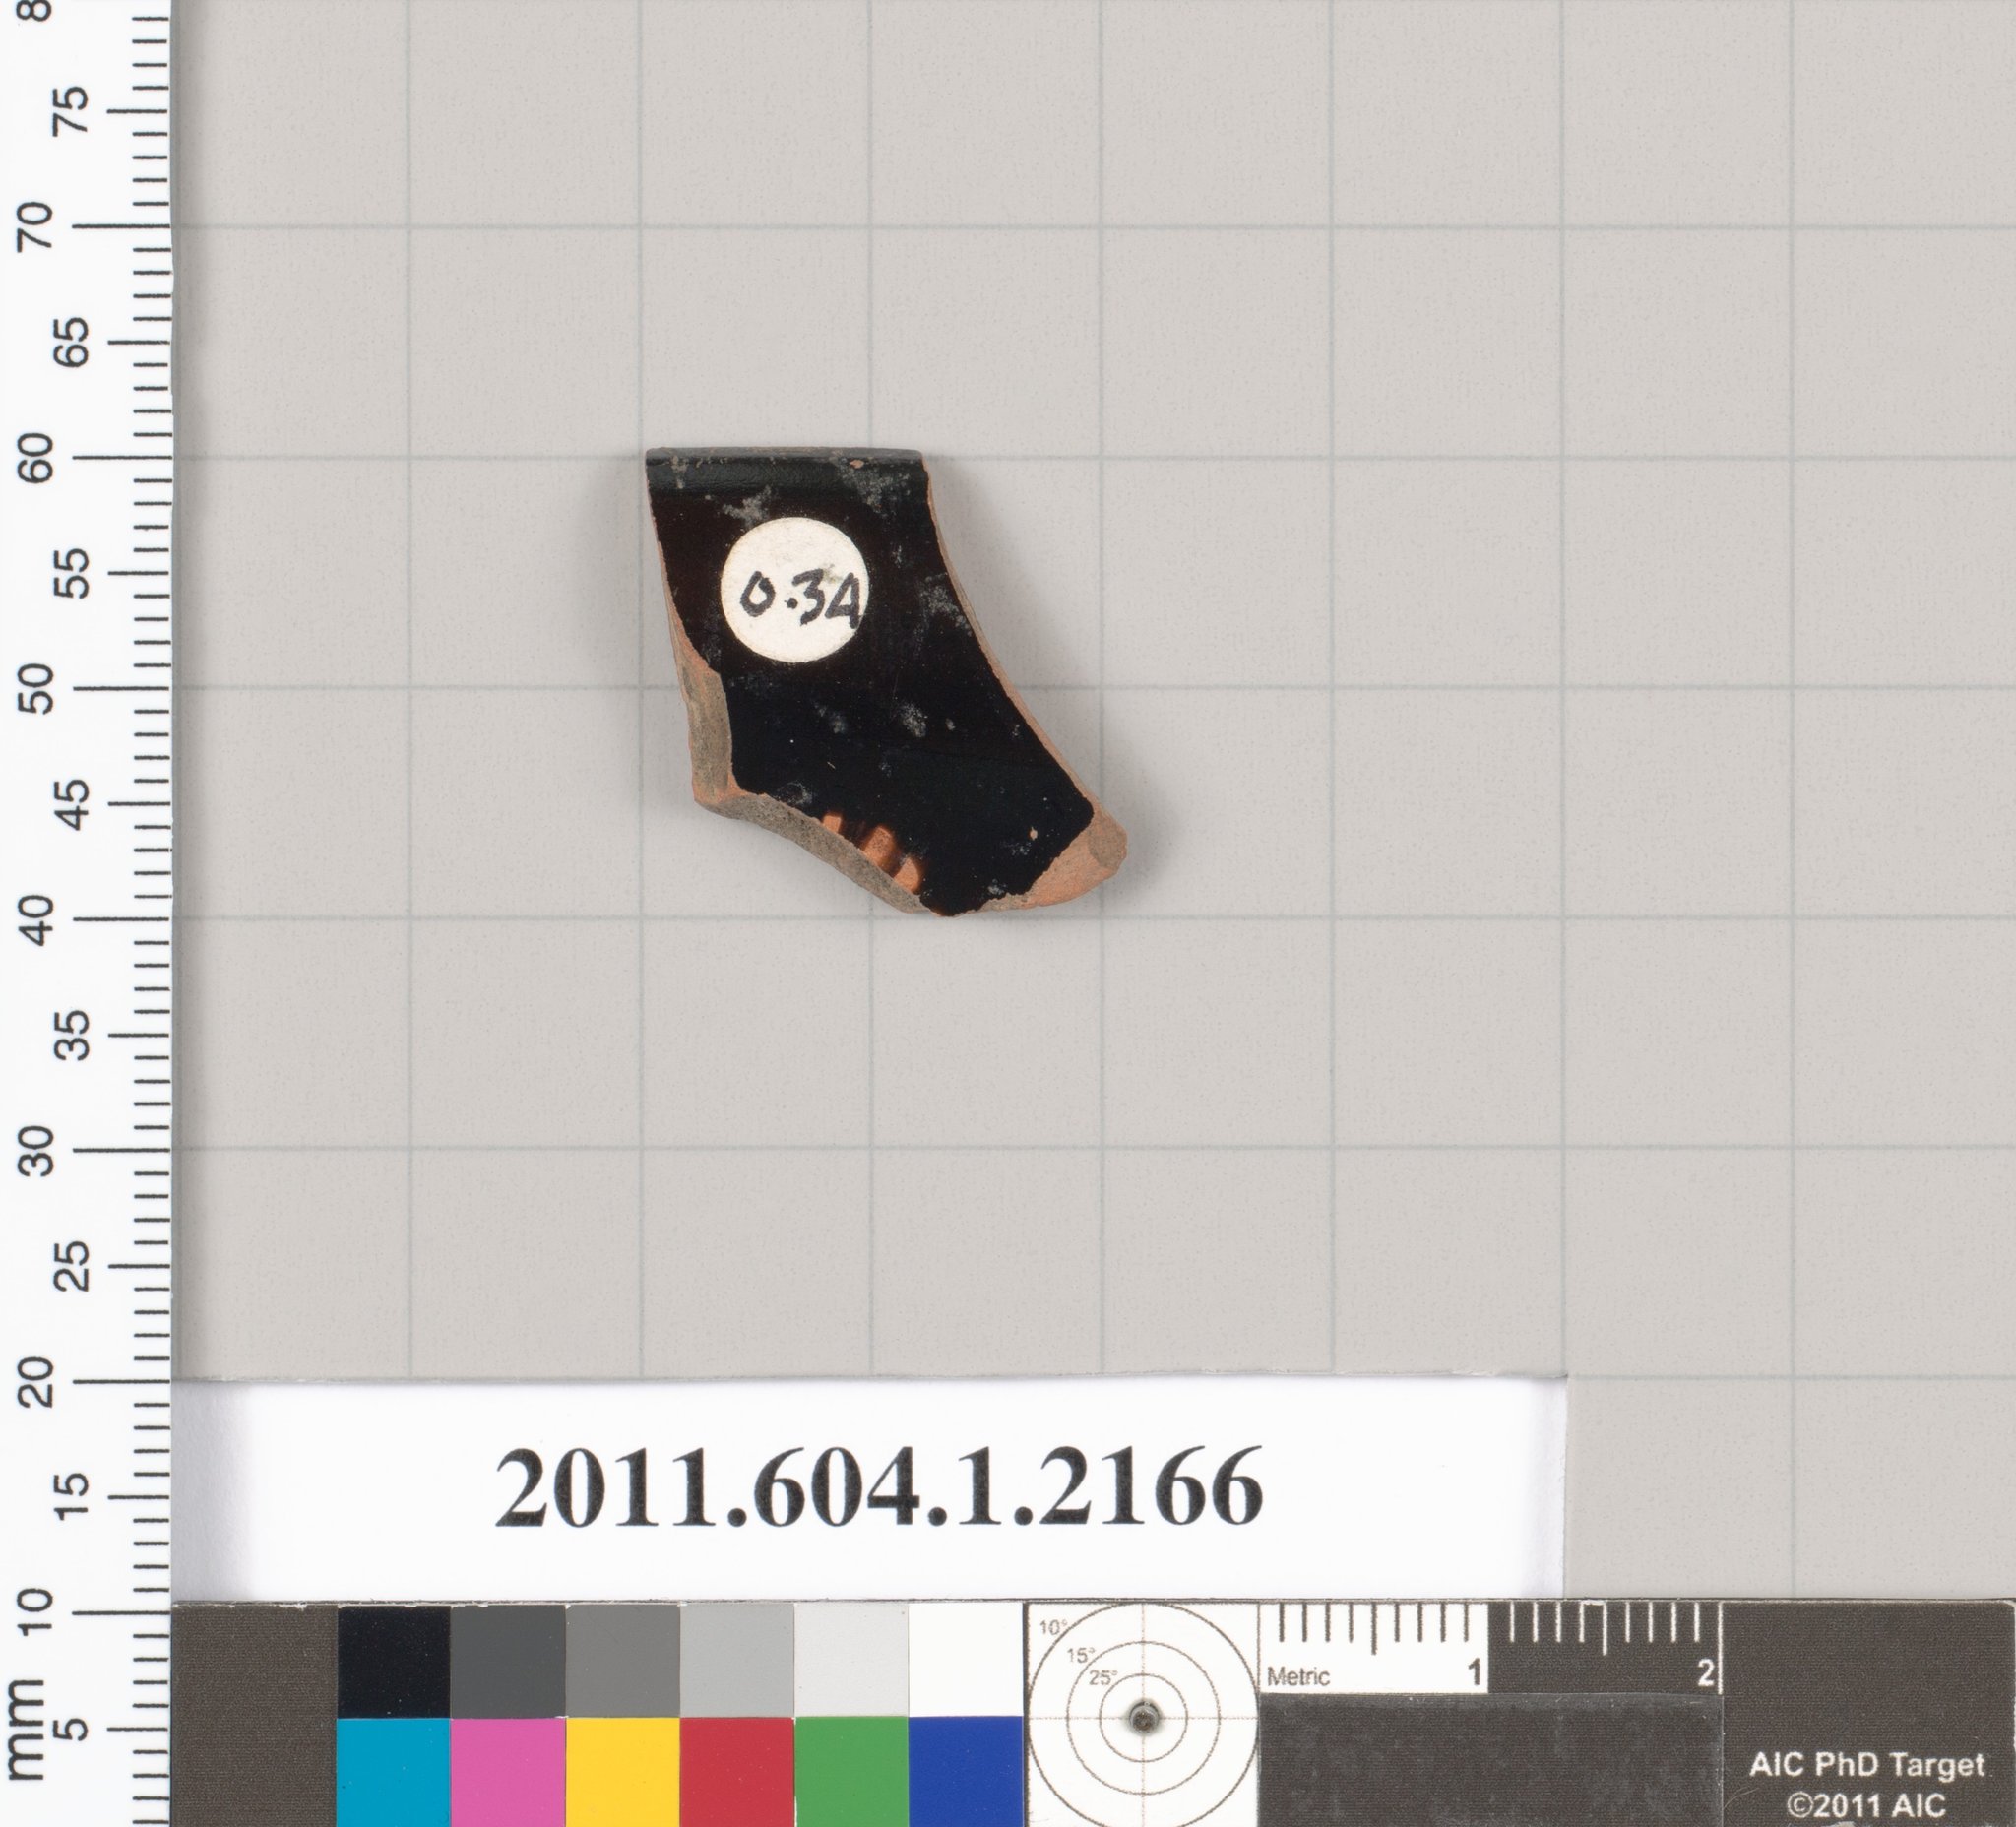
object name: kylix fragment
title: Terracotta rim fragment of a kylix (drinking cup)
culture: greek, attic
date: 500-401 BCE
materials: terracotta